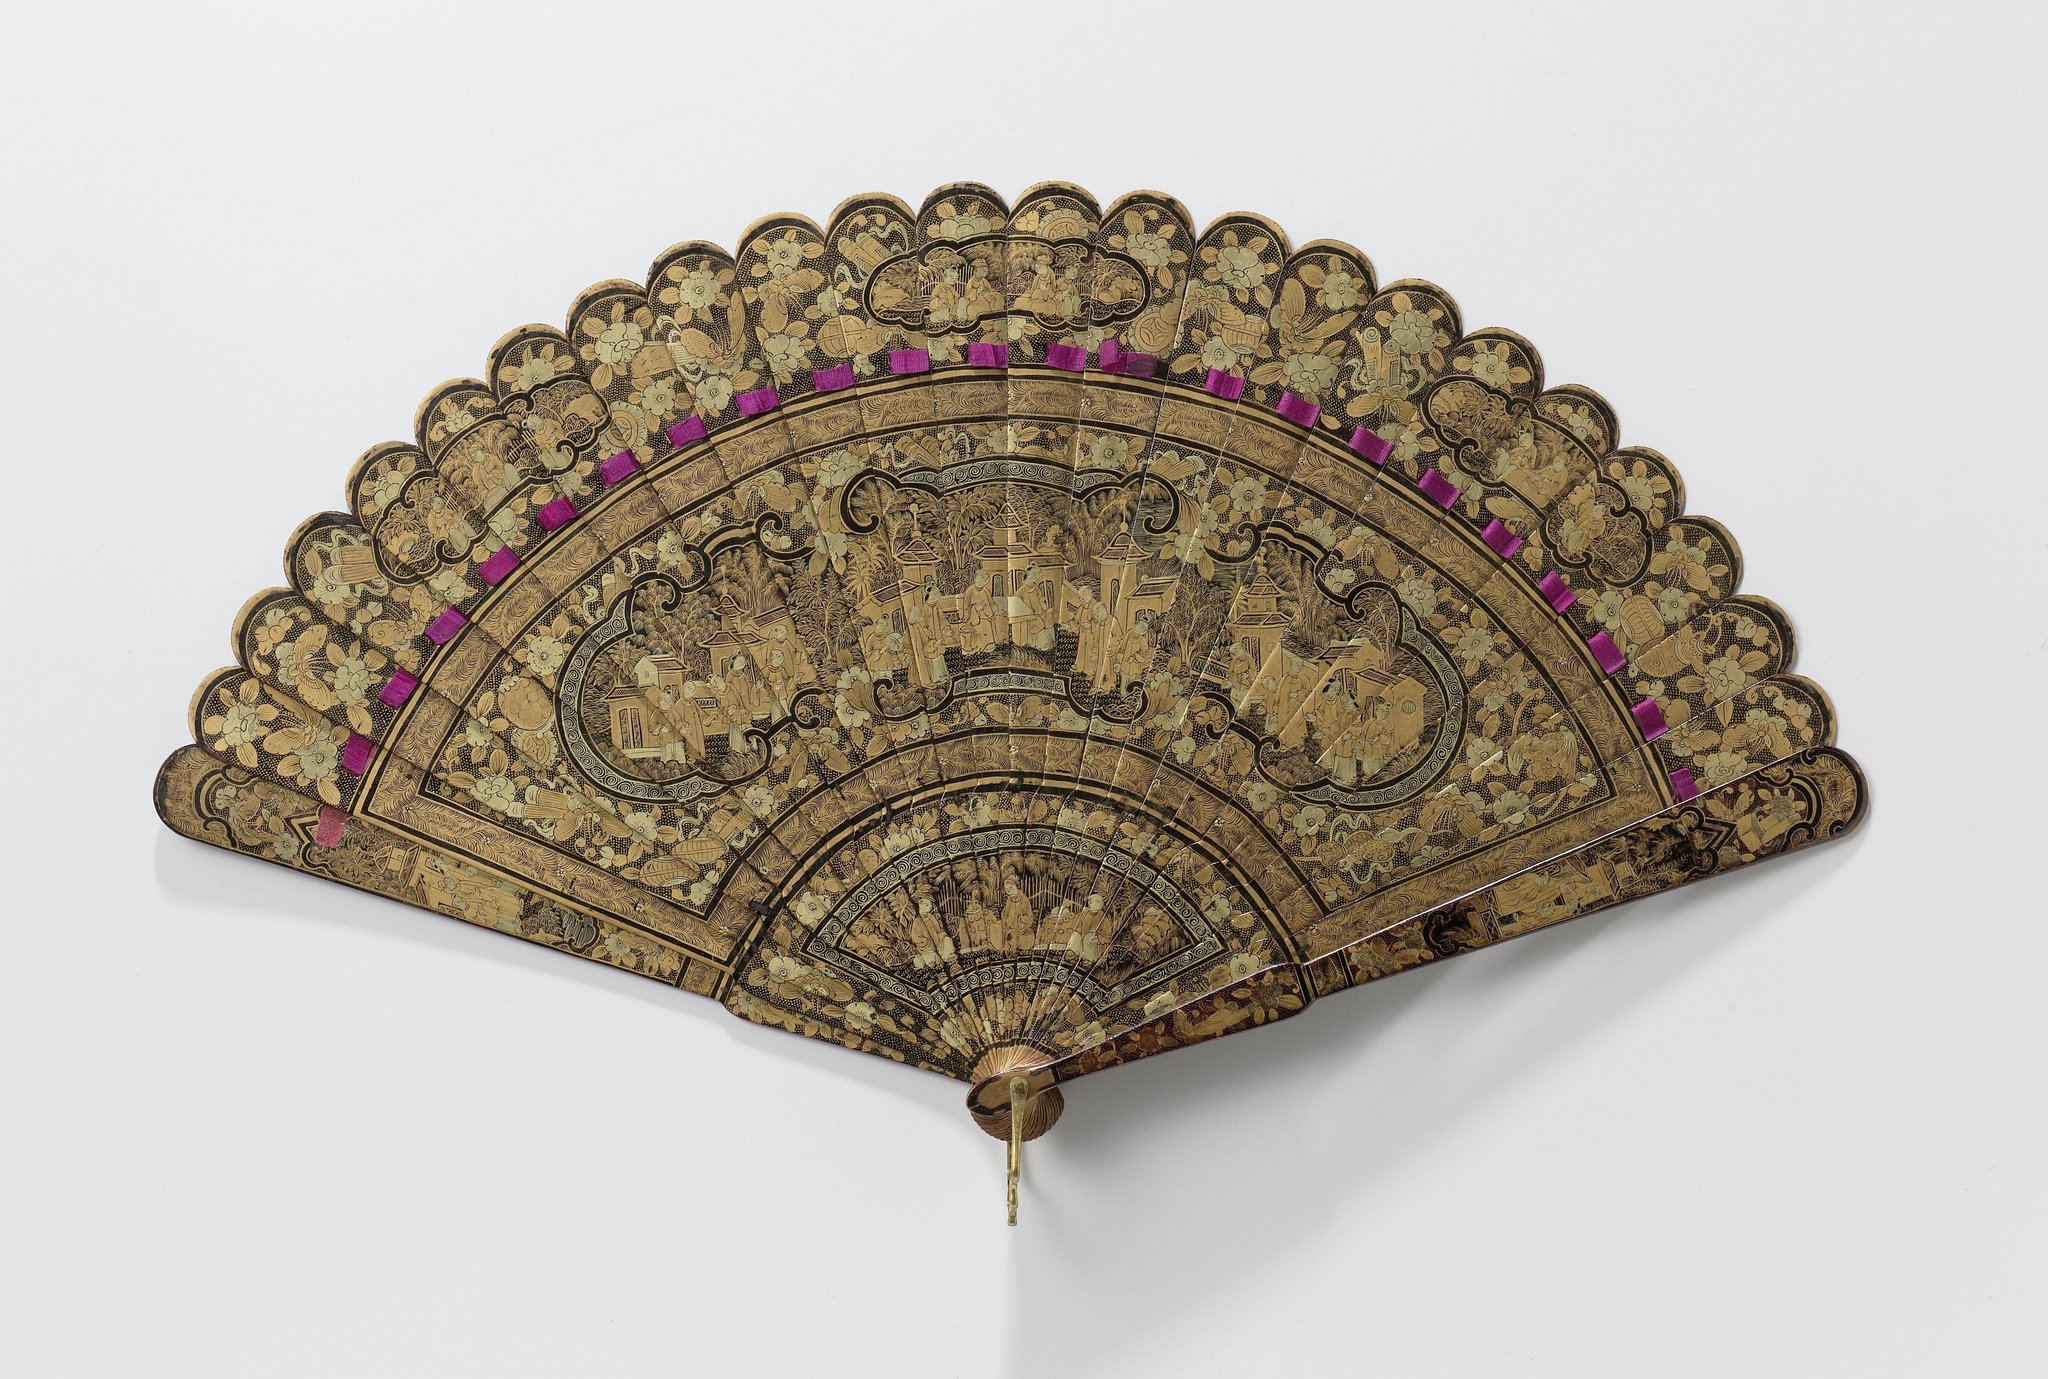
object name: brisé fan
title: Brisé-waaier van hout waarop aan beide kanten een Chinees tafereel in een cartouche in lakwerk van twee kleuren goud op een zwarte ondergrond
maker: Anonymous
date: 1840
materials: copper, lacquer, silk, wood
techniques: cutting, lacquer, weave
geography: guangdong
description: Brisé-waaier van hout waarop aan beide kanten een Chinees tafereel een cartouche in lakwerk van twee kleuren goud op een zwarte ondergrond. De waaier telt 24 aaneengesloten benen die met een paars satijnen lintje samengehouden worden. De drie kleine cartouches tegen de bovenrand en de grote centrale cartouche bevatten Chineze figuren bij paviljoens. De compartimenten zijn omlijst met een band waarin veren of spiraalachtige vormen. De achtergrond van de waaier bestaat uit een bruinzwarte korrel en met grote roodgouden bloemen. Het verschil met de voor- en achterkant van de waaier is slechts een detail: een ronde danwel een vierkante tafel. De waaierring is van metaal.